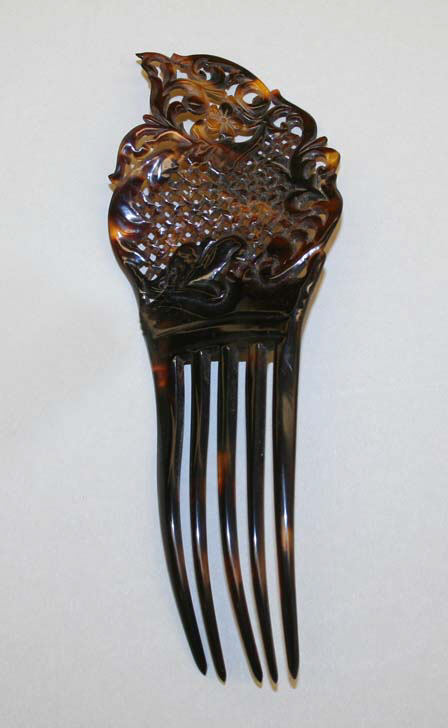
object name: comb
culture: american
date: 1801-1900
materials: shell